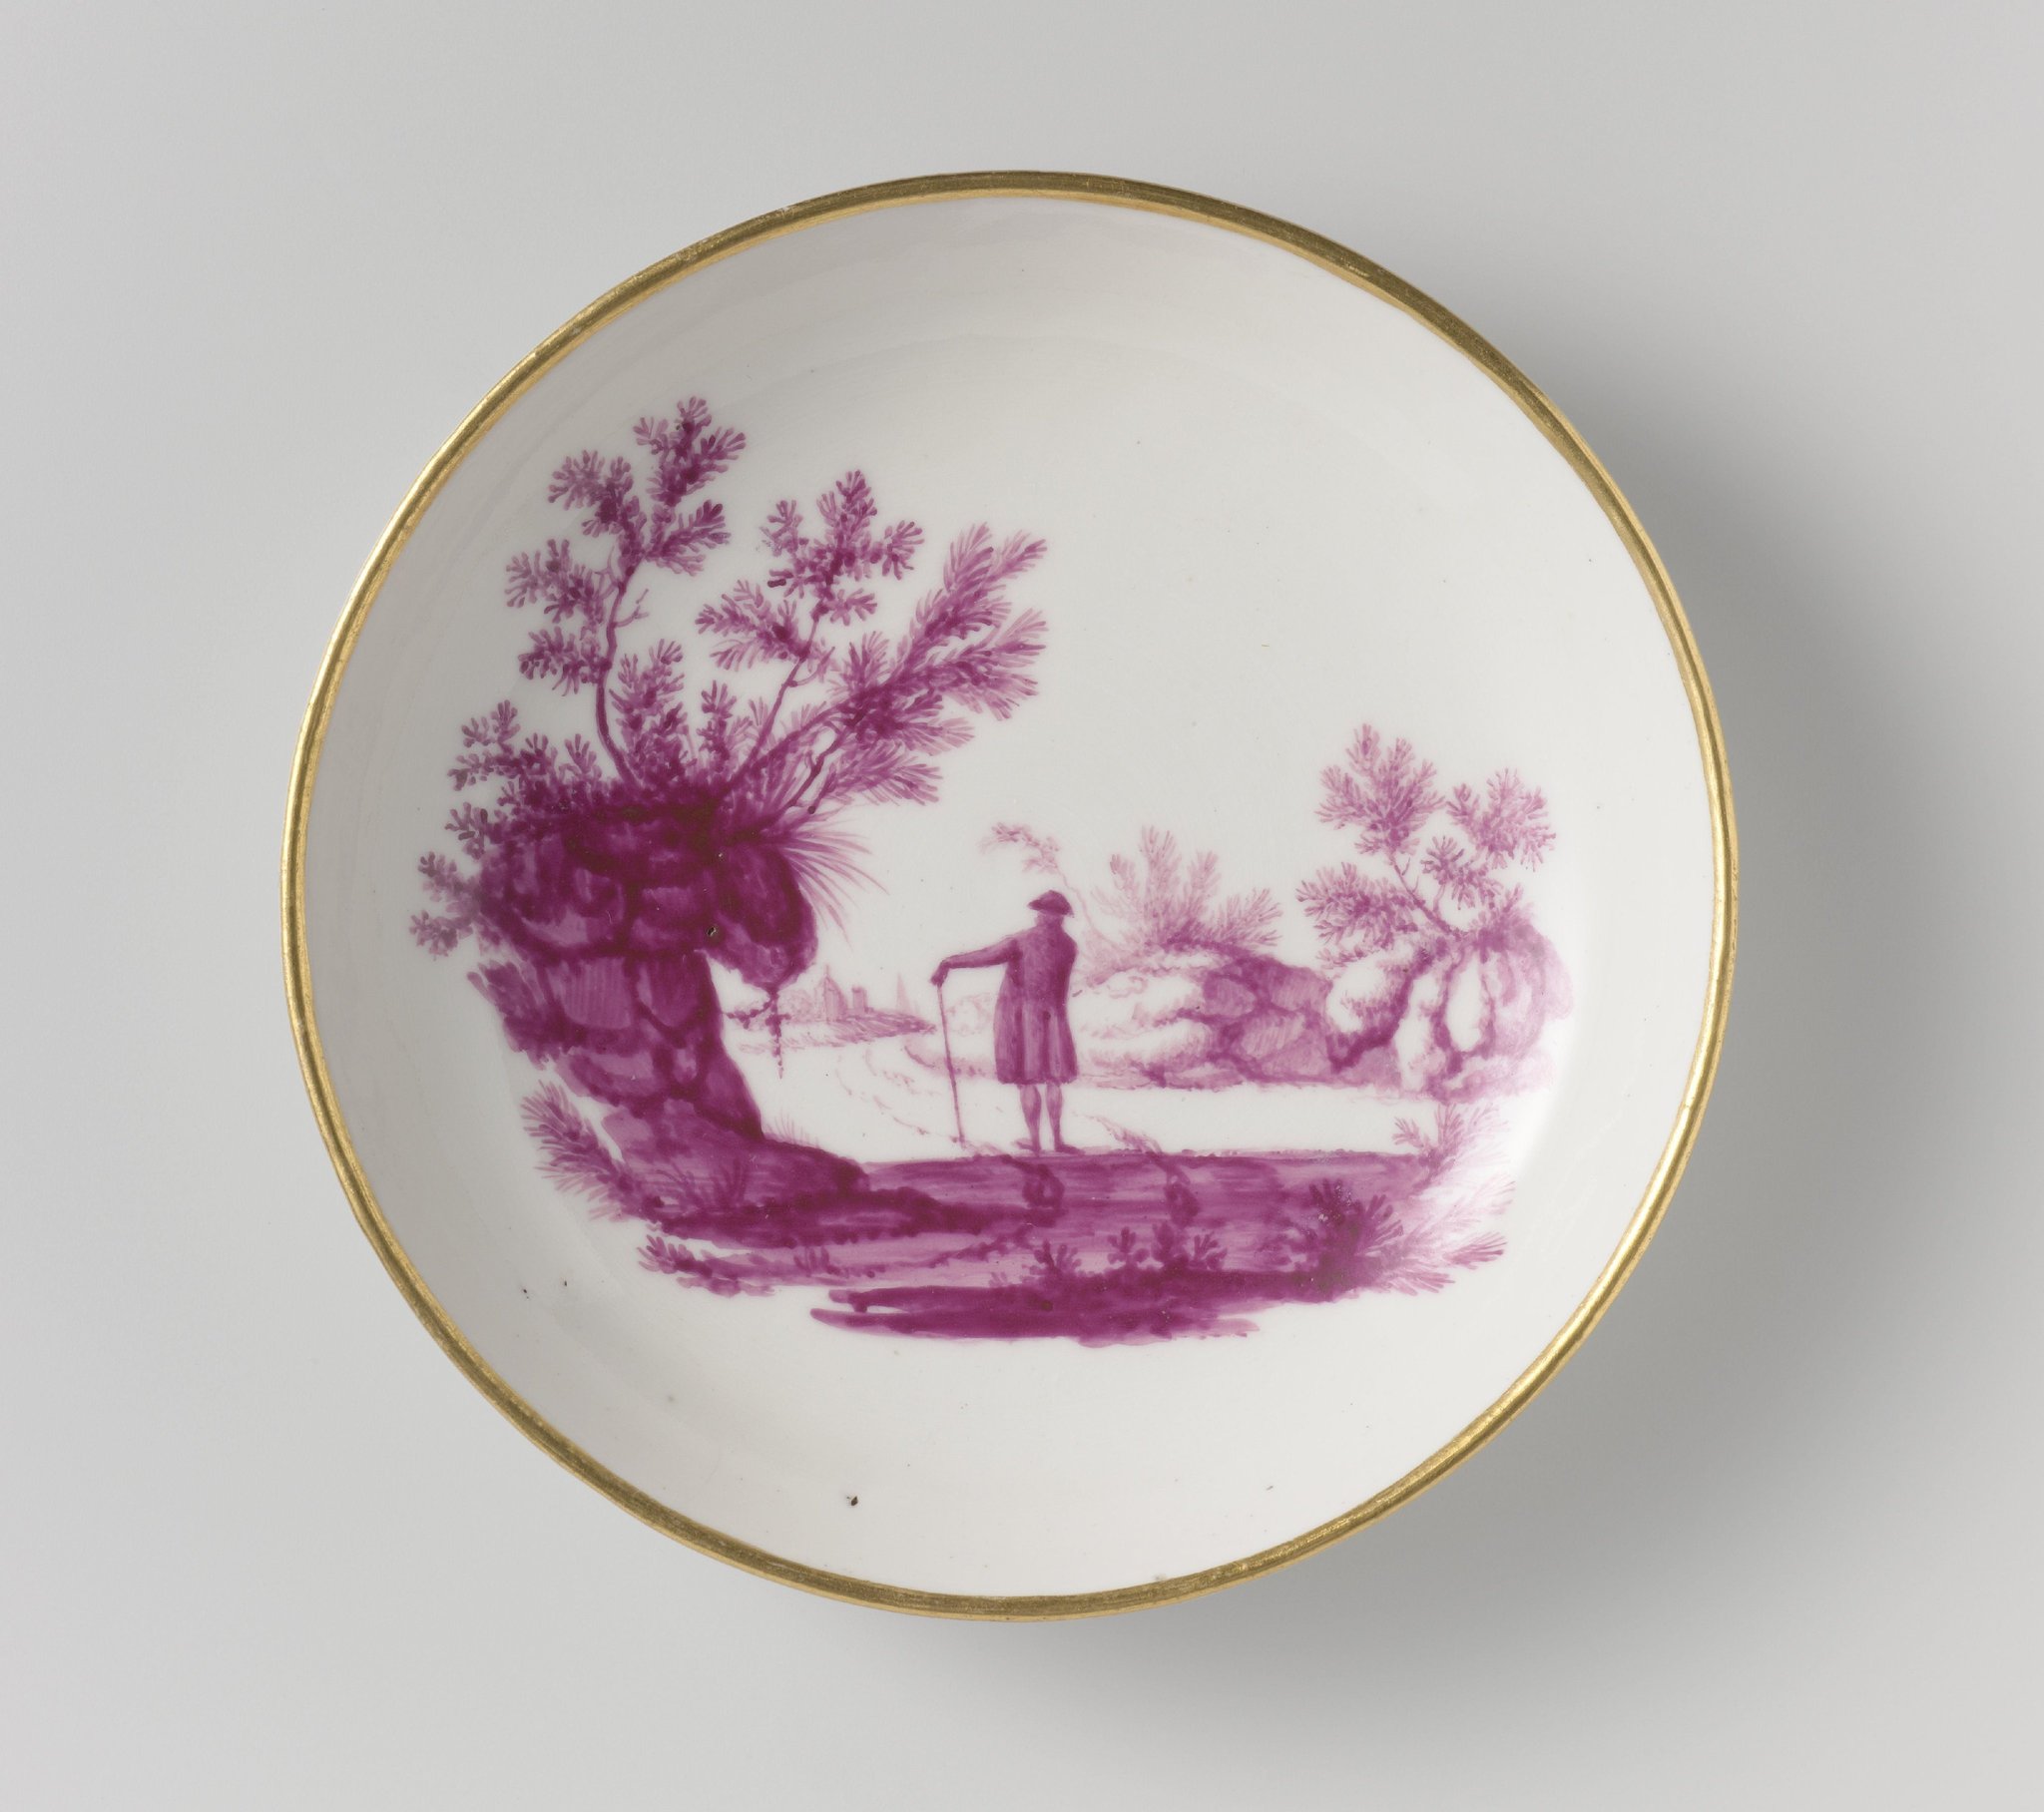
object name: platter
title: Schotel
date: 1775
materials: porcelain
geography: loosdrecht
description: Schotel van porselein. Onderdeel van een serie van twaafl stuks. Beschilderd met figuren in een landschap in bietenrood en gouden biezen.